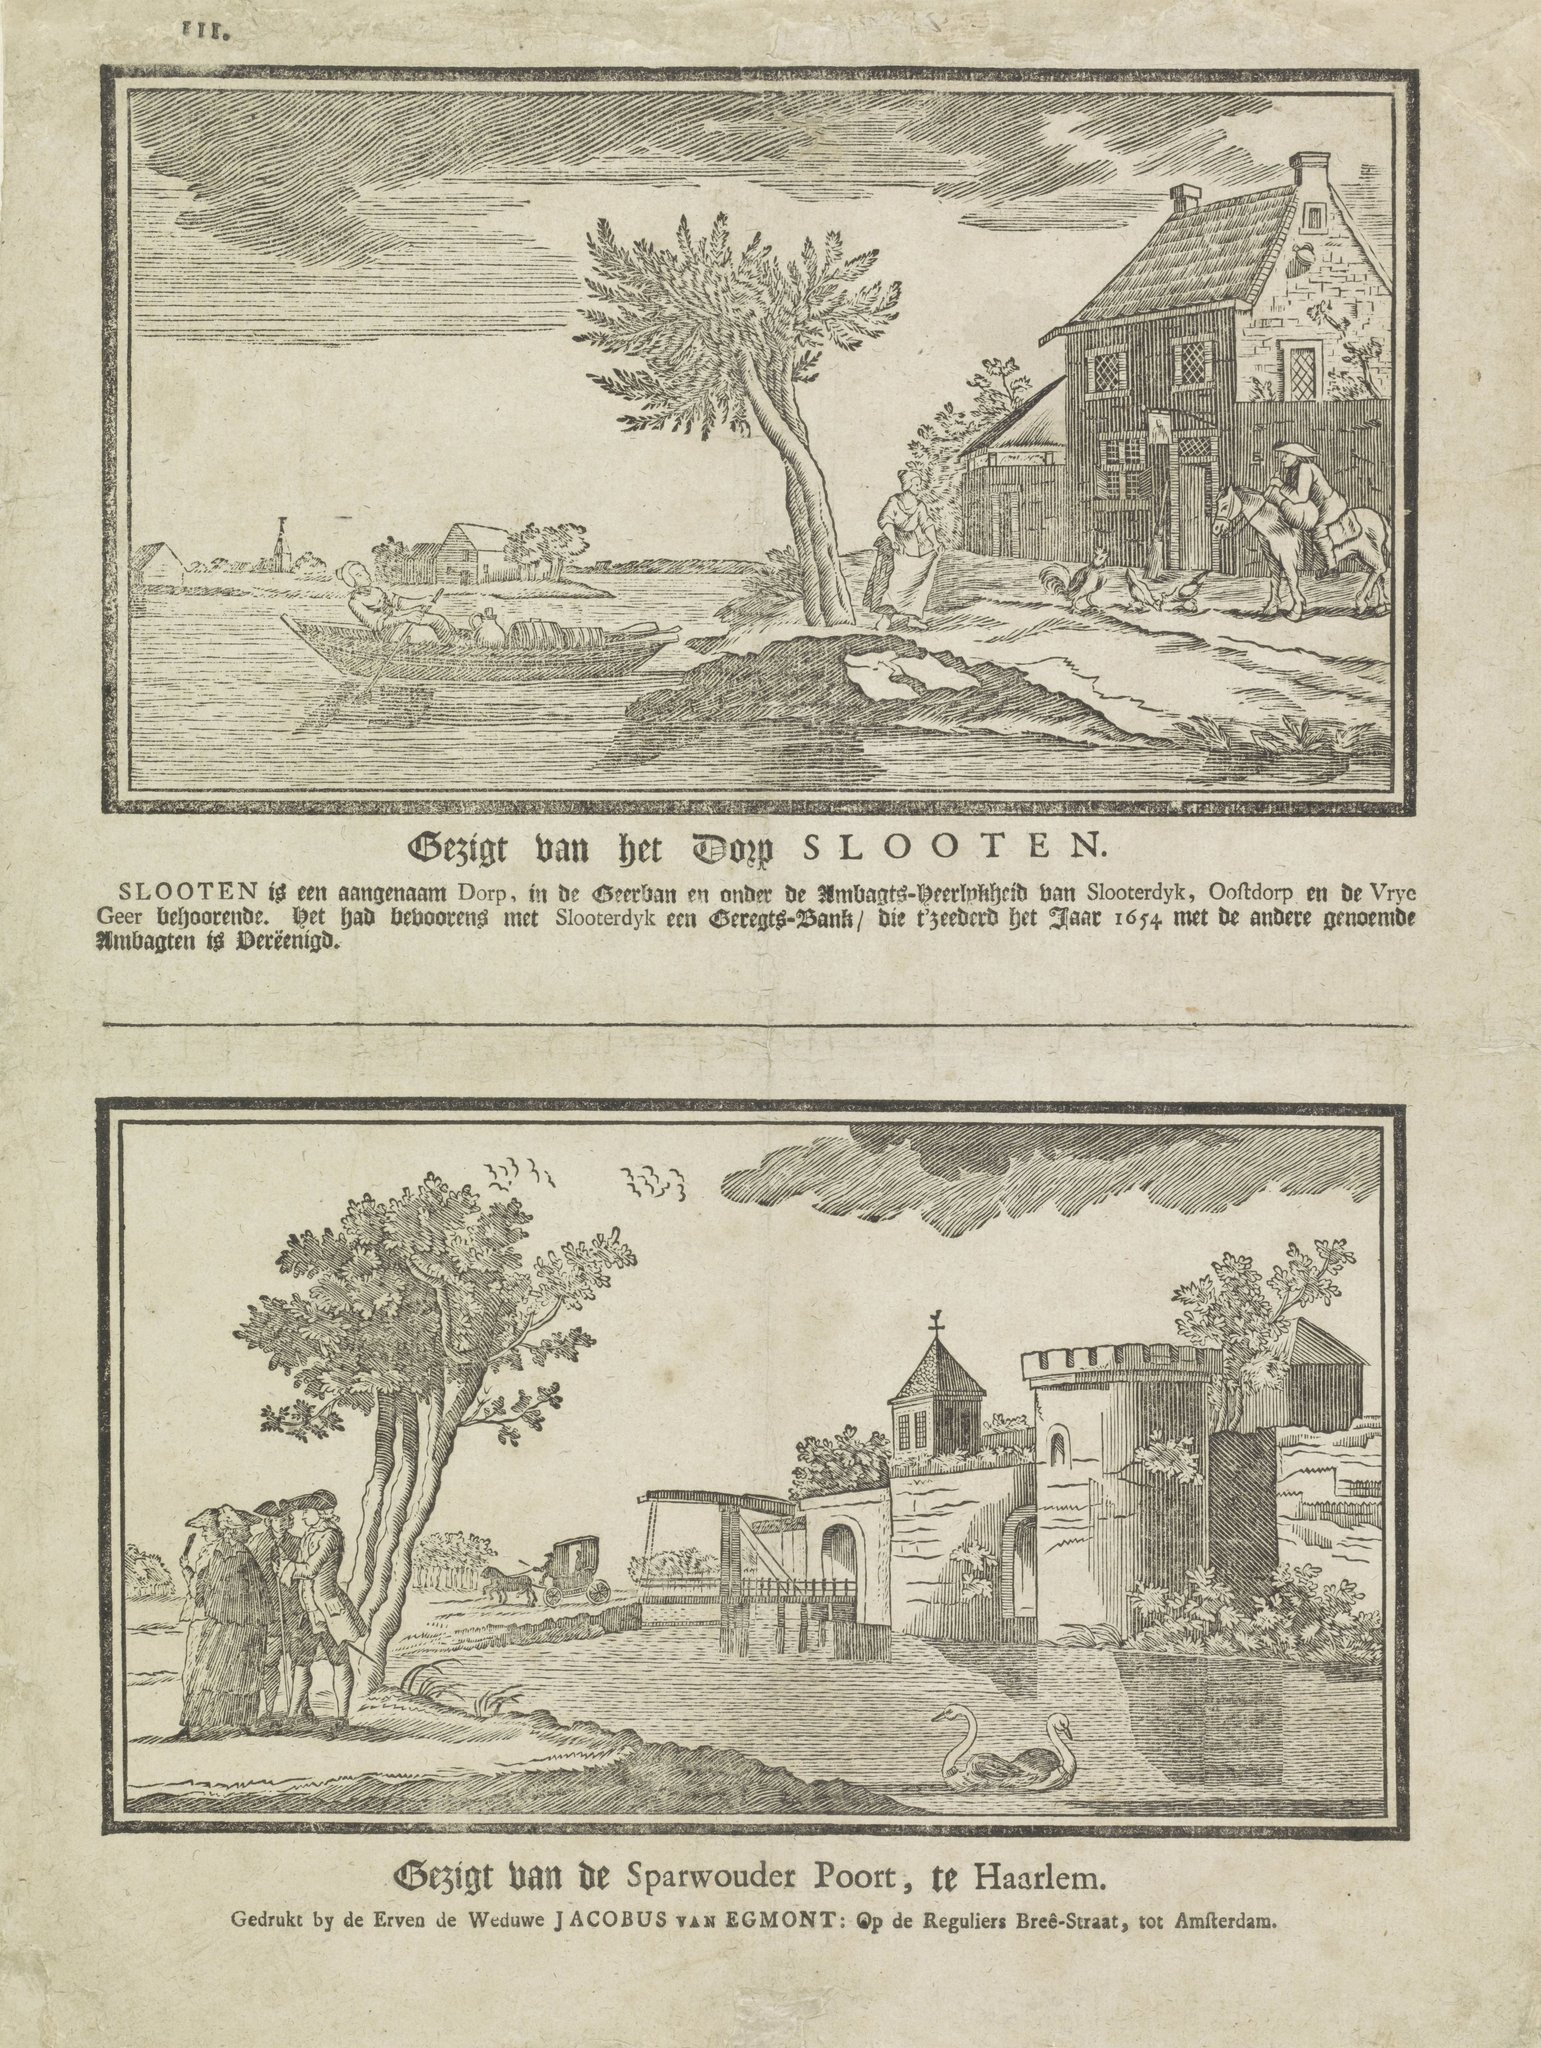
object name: popular print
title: Gezigt van het dorp Slooten / Gezigt van de Sparwouder Poort, te Haarlem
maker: Anonymous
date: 1761-1804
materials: paper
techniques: letterpress printing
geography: amsterdam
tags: city-view, and landscape with man-made constructions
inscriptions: collector's mark: Lugt 2760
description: Blad met 2 voorstelling. Boven: een gezicht op Sloten. Onder: een gezicht op de Spaarnwouderpoort te Haarlem. Onder elke voorstelling een titel en een onderschrift. Genummerd linksboven: 111.